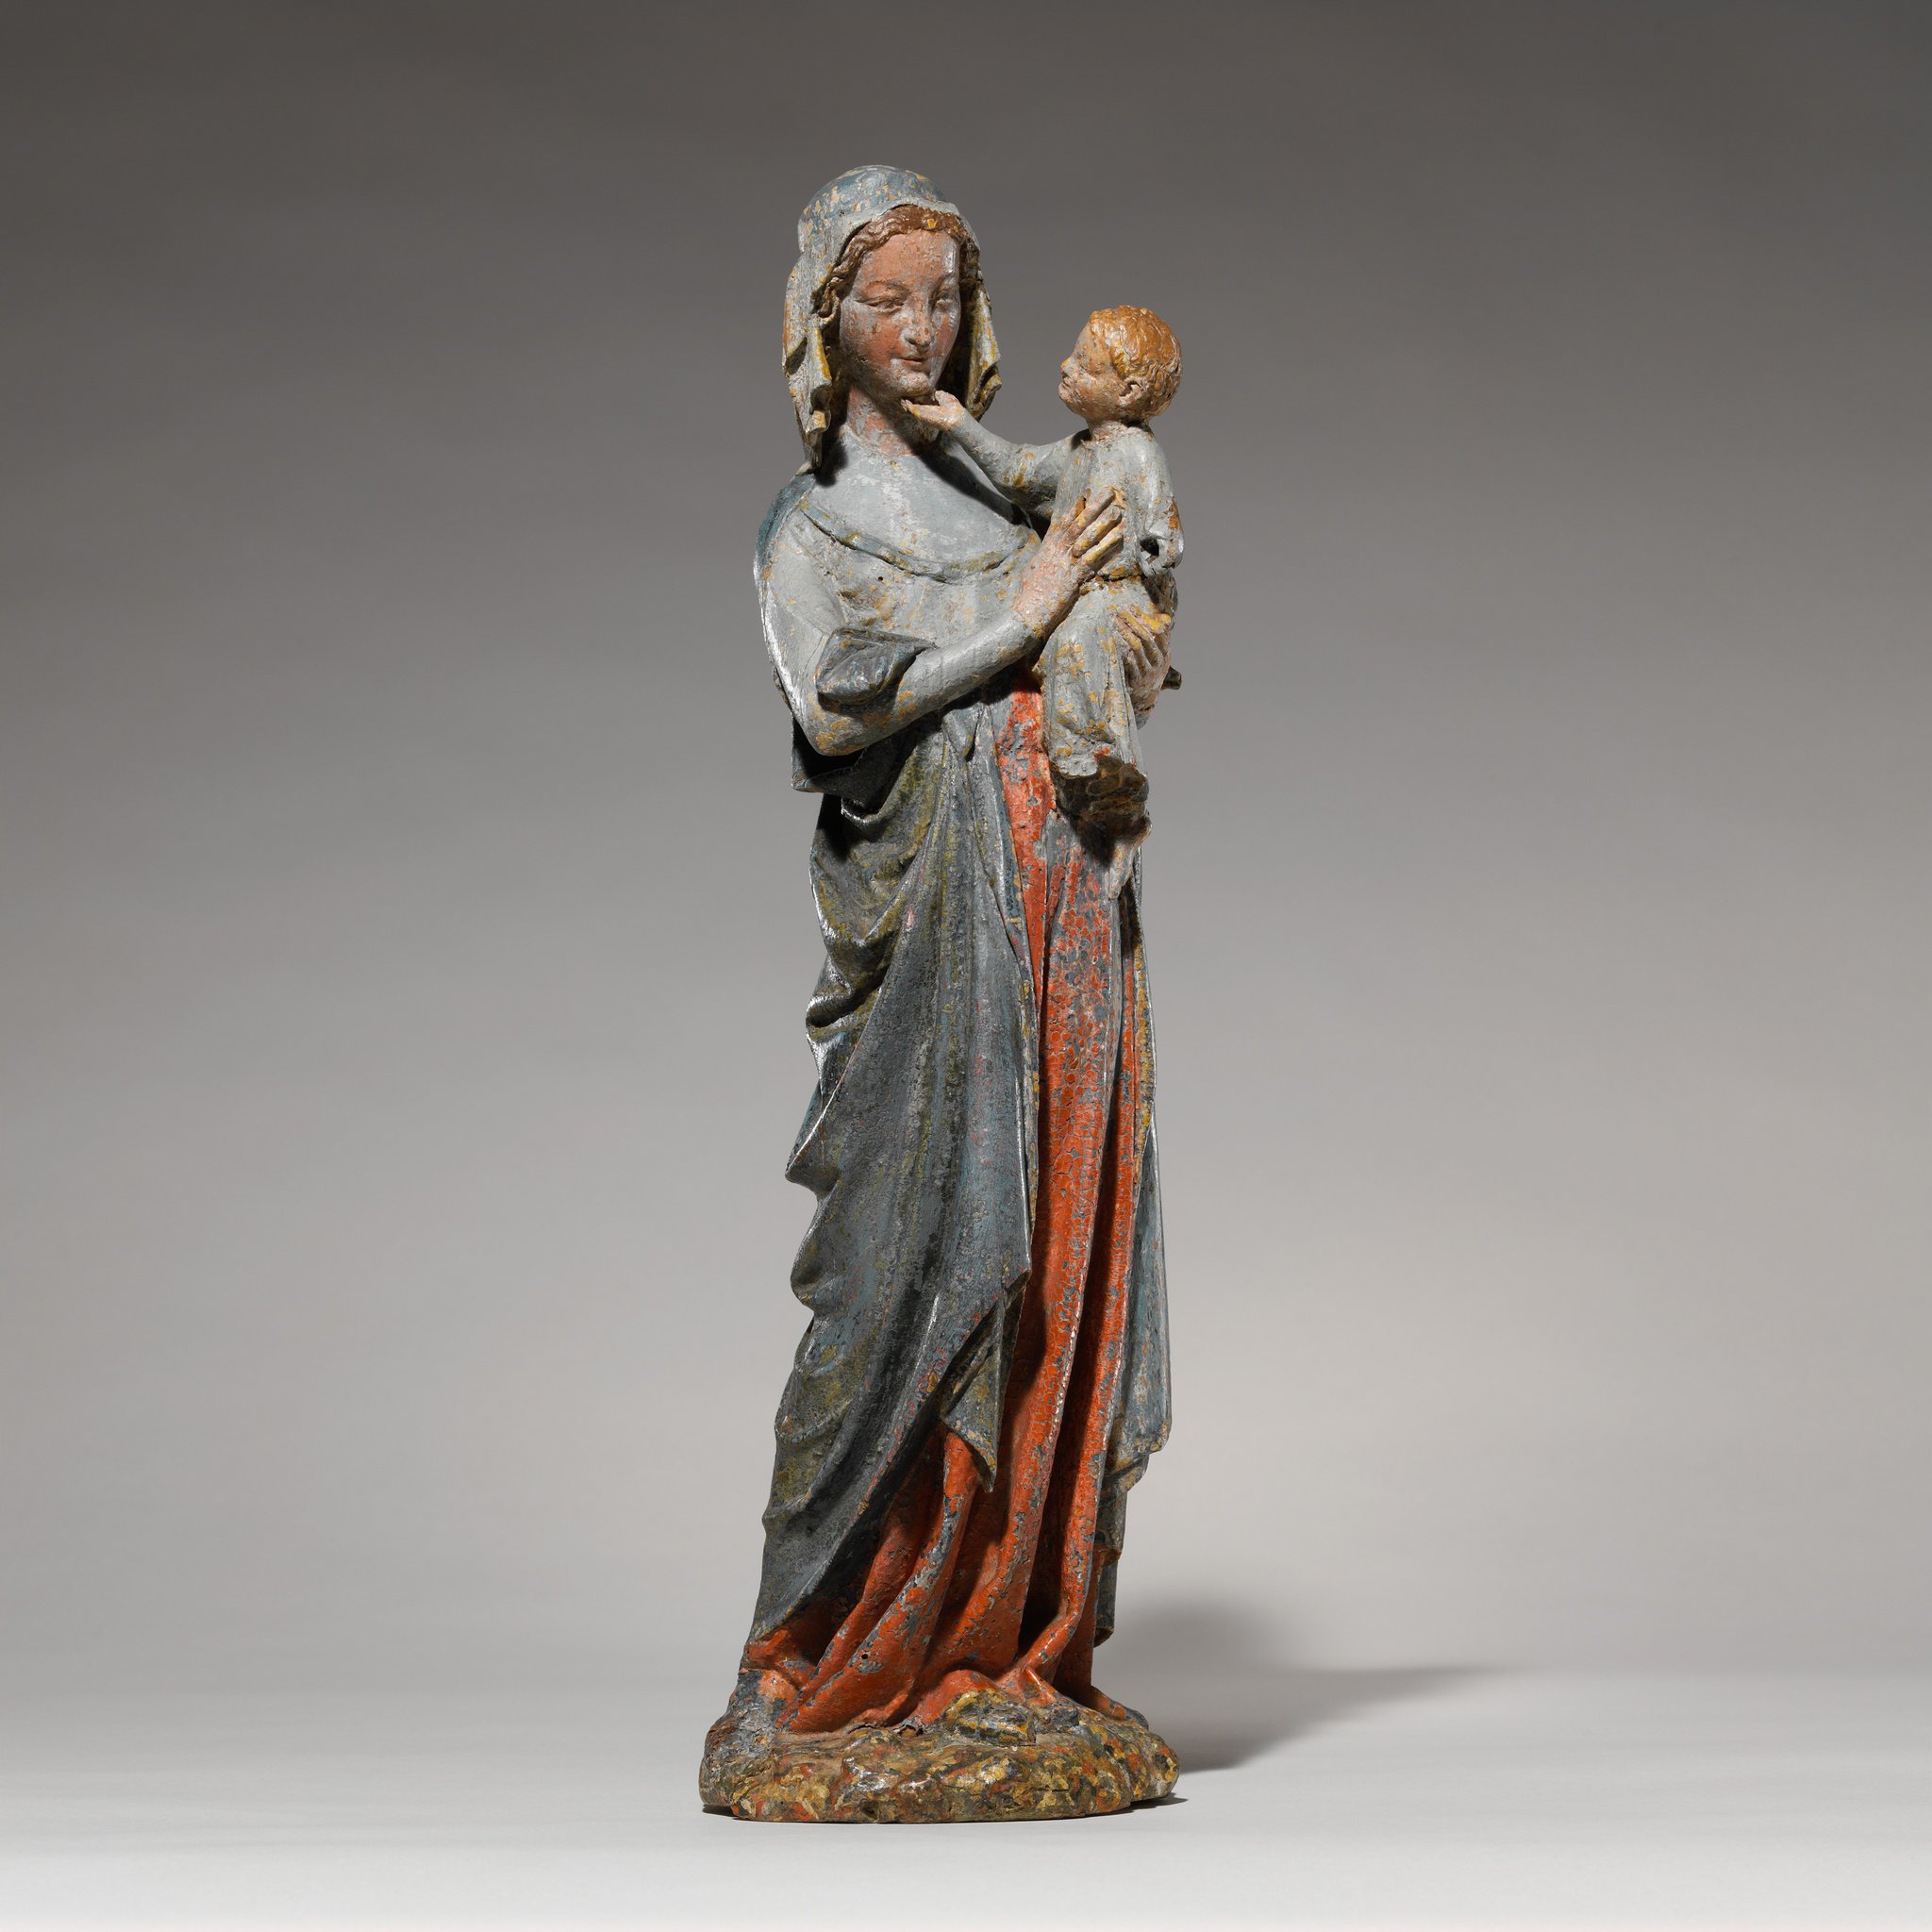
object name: statuette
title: Devotional Statuette of the Virgin and Child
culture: french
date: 1250-1270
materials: wood, paint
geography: france